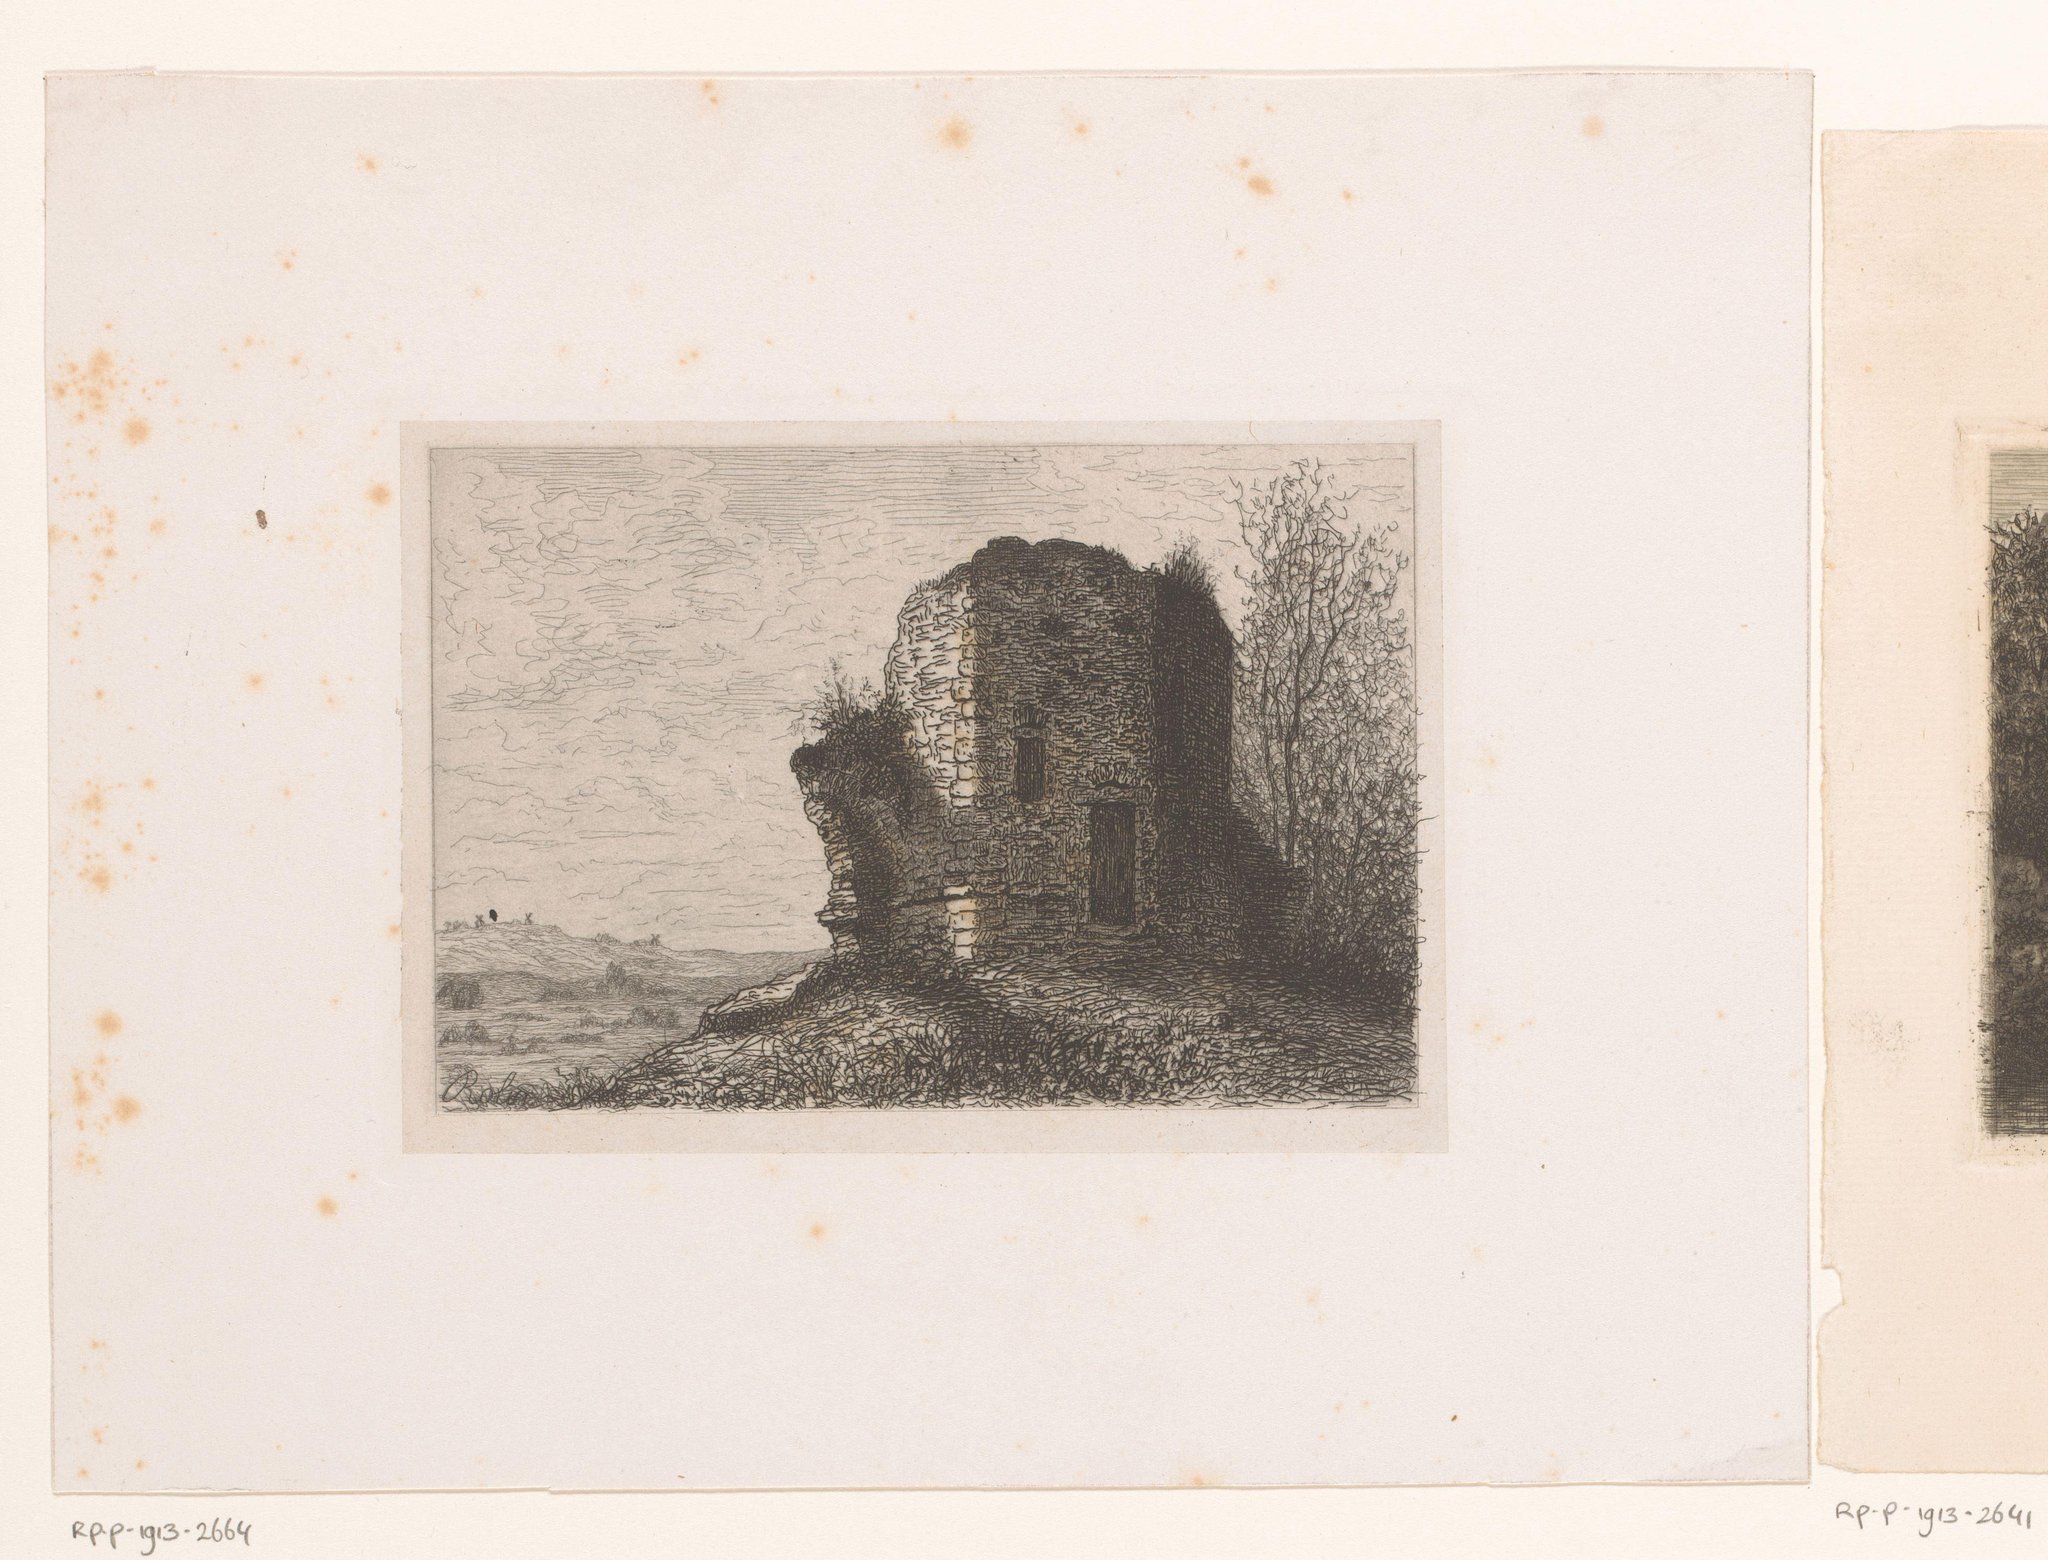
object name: print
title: Ruïne van een toren te Aarschot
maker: emilie rolin-jacquemijns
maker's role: print maker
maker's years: 1842-1906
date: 1852-1906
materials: paper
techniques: etching, intaglio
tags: landscape with ruins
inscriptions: collector's mark: Lugt 2228